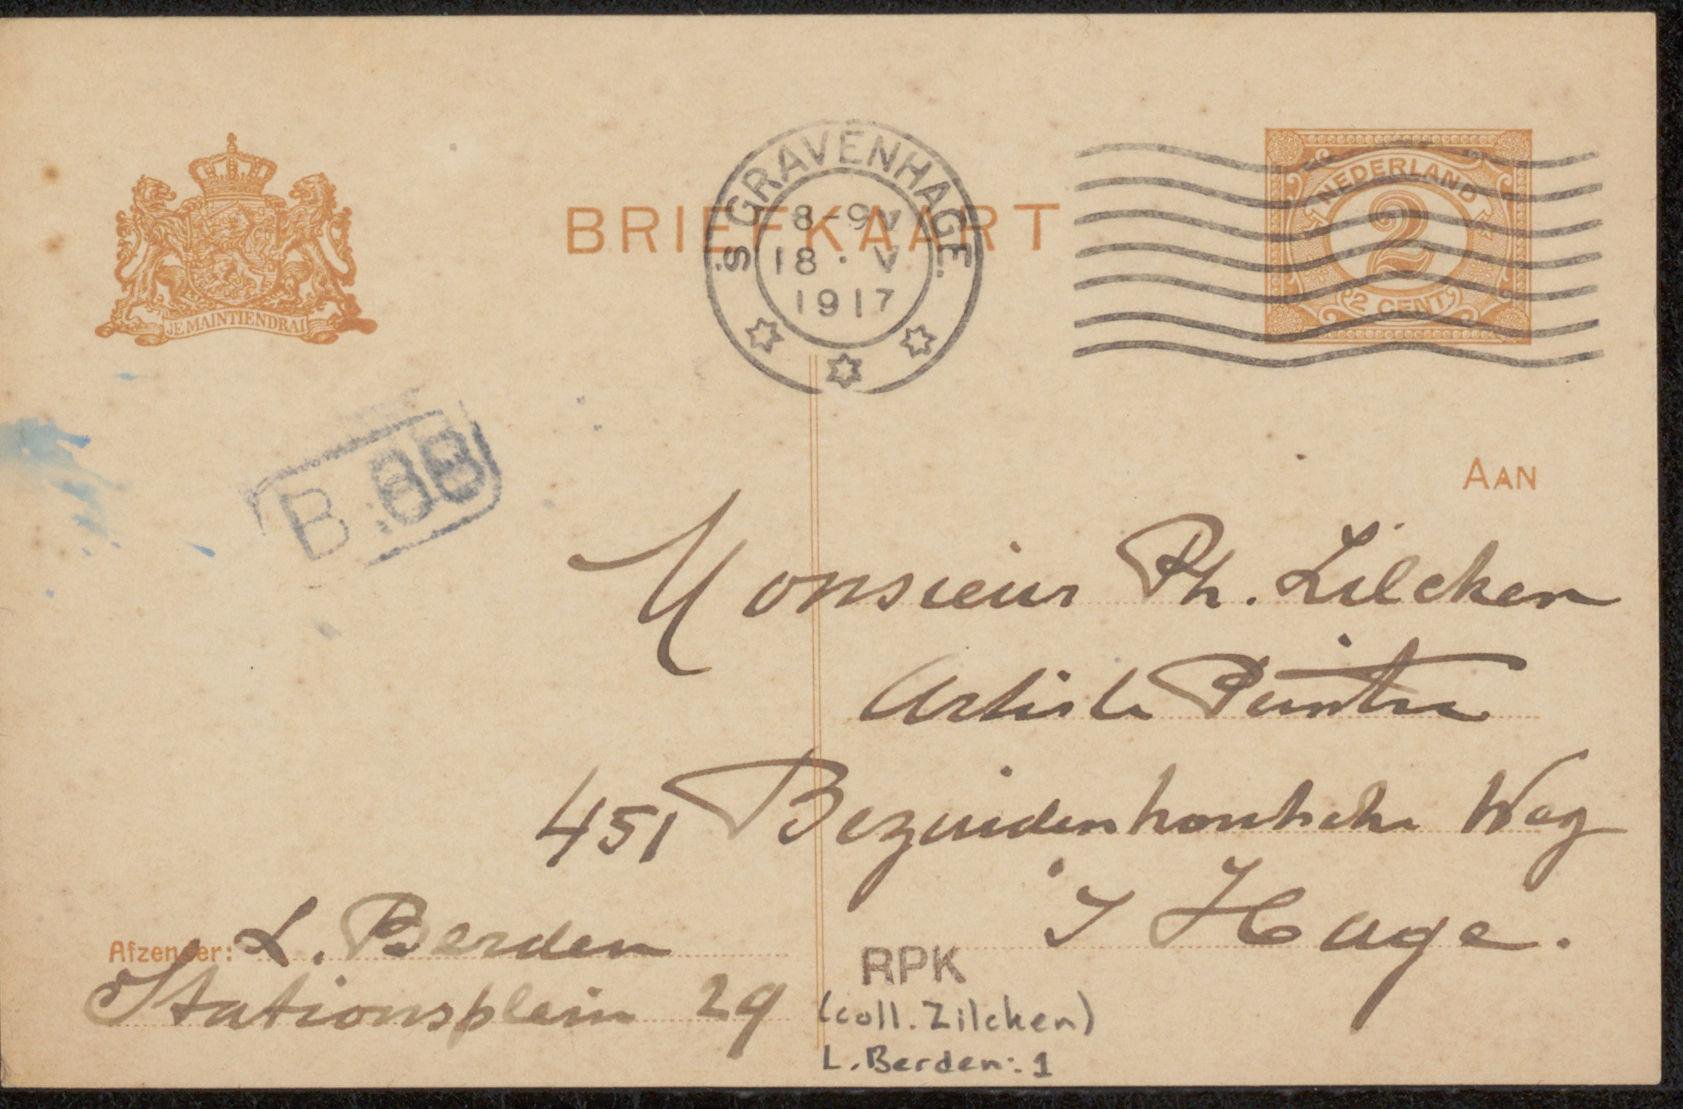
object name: postcard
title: Briefkaart aan Philip Zilcken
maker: l. berden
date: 1917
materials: cardboard, ink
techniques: pen, writing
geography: the hague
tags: the hague, painter, draughtsman, philip zilcken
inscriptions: collector's mark: ‘RPK’